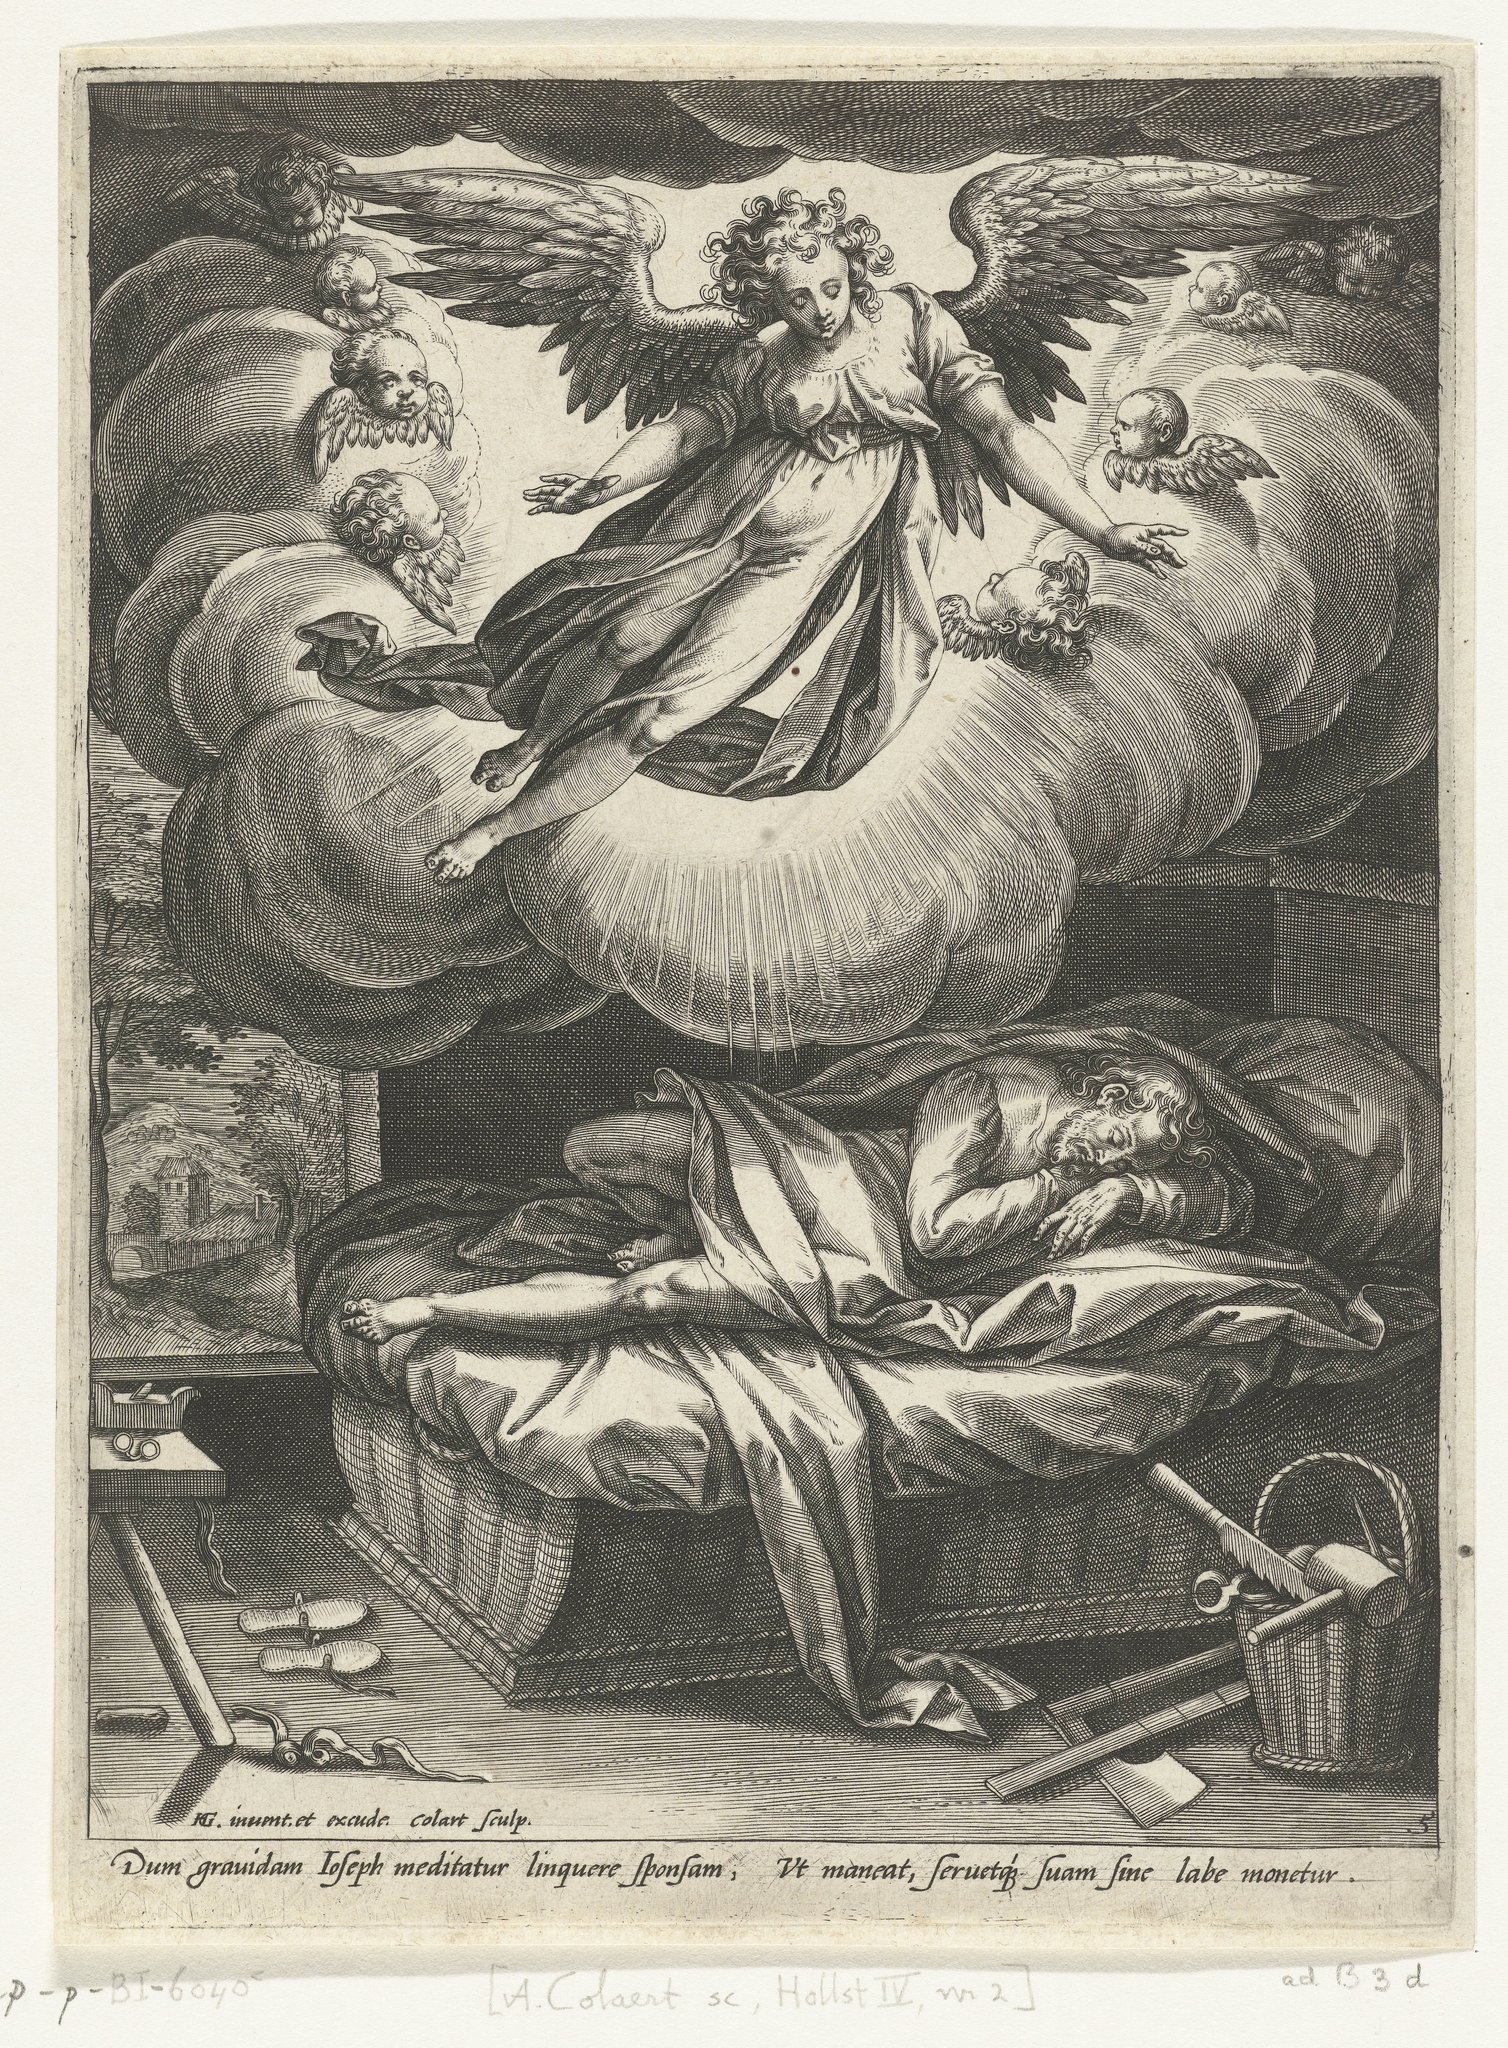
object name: print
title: Aankondiging van de geboorte van Christus aan Jozef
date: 1586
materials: paper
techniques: engraving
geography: haarlem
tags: joseph worrying about mary's pregnancy; annunciation to joseph in a dream (matthew 1:19:25)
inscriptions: collector's mark: Lugt 240, signature, date and inscription: ‘HG inuent et excud. Colart sculp’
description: Goltzius heeft deze prent ontworpen en uitgegeven. Het vervaardigen van de plaat is echter uitgevoerd door Adriaen Collaert. Serie van zes, alle exemplaren aanwezig in het RPK. Jacobs, G.